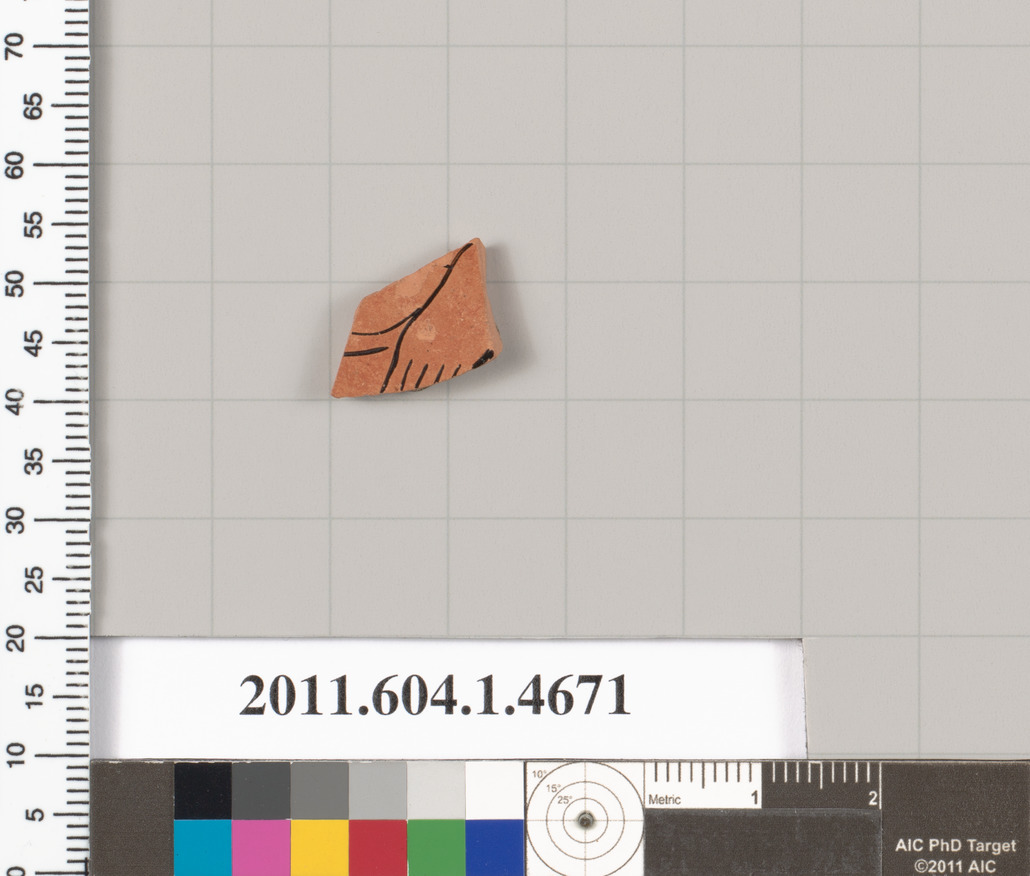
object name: kylix fragment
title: Terracotta fragment of a kylix (drinking cup)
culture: greek, attic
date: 475-451 BCE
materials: terracotta